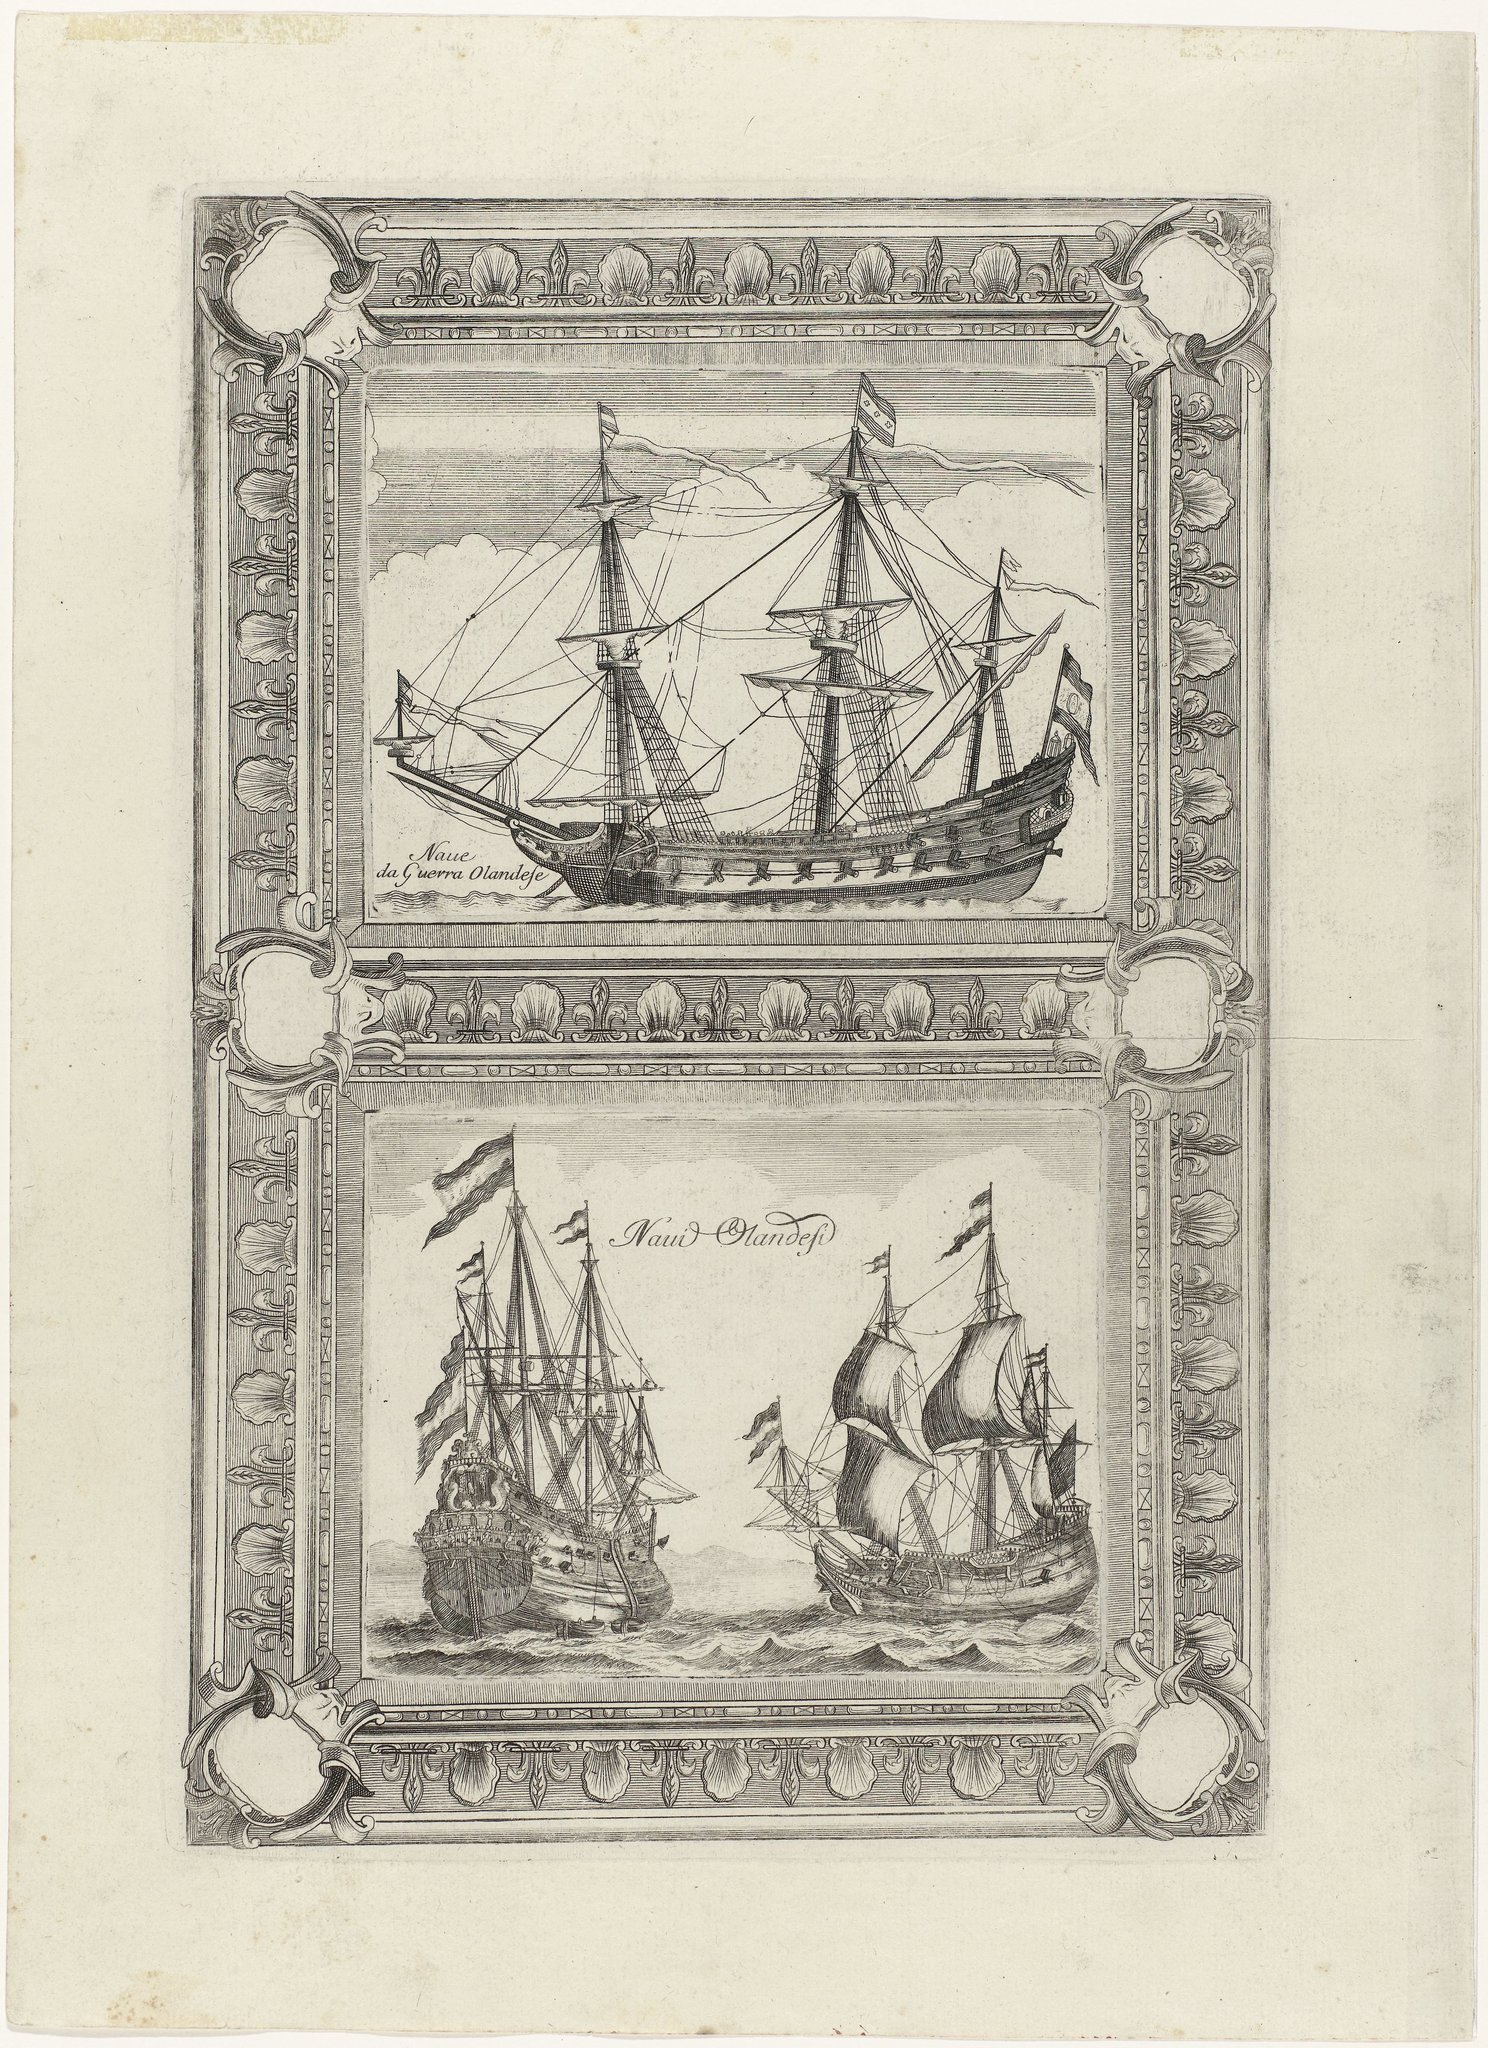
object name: print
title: Hollandse schepen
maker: vicenzo maria coronelli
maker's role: print maker, publisher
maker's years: 1650-1718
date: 1660-1718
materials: paper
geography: italy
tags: sailing-ship, sailing-boat, ships (in general)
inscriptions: collector's mark: Lugt 2228, collector's mark: Lugt 2760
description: Blad met twee voorstellingen van driemasters (oorlogsschepen en fregatten) in een ornamentlijst. Boven een oorlogsschip varend op zee. Onder twee fregatten varend op zee.